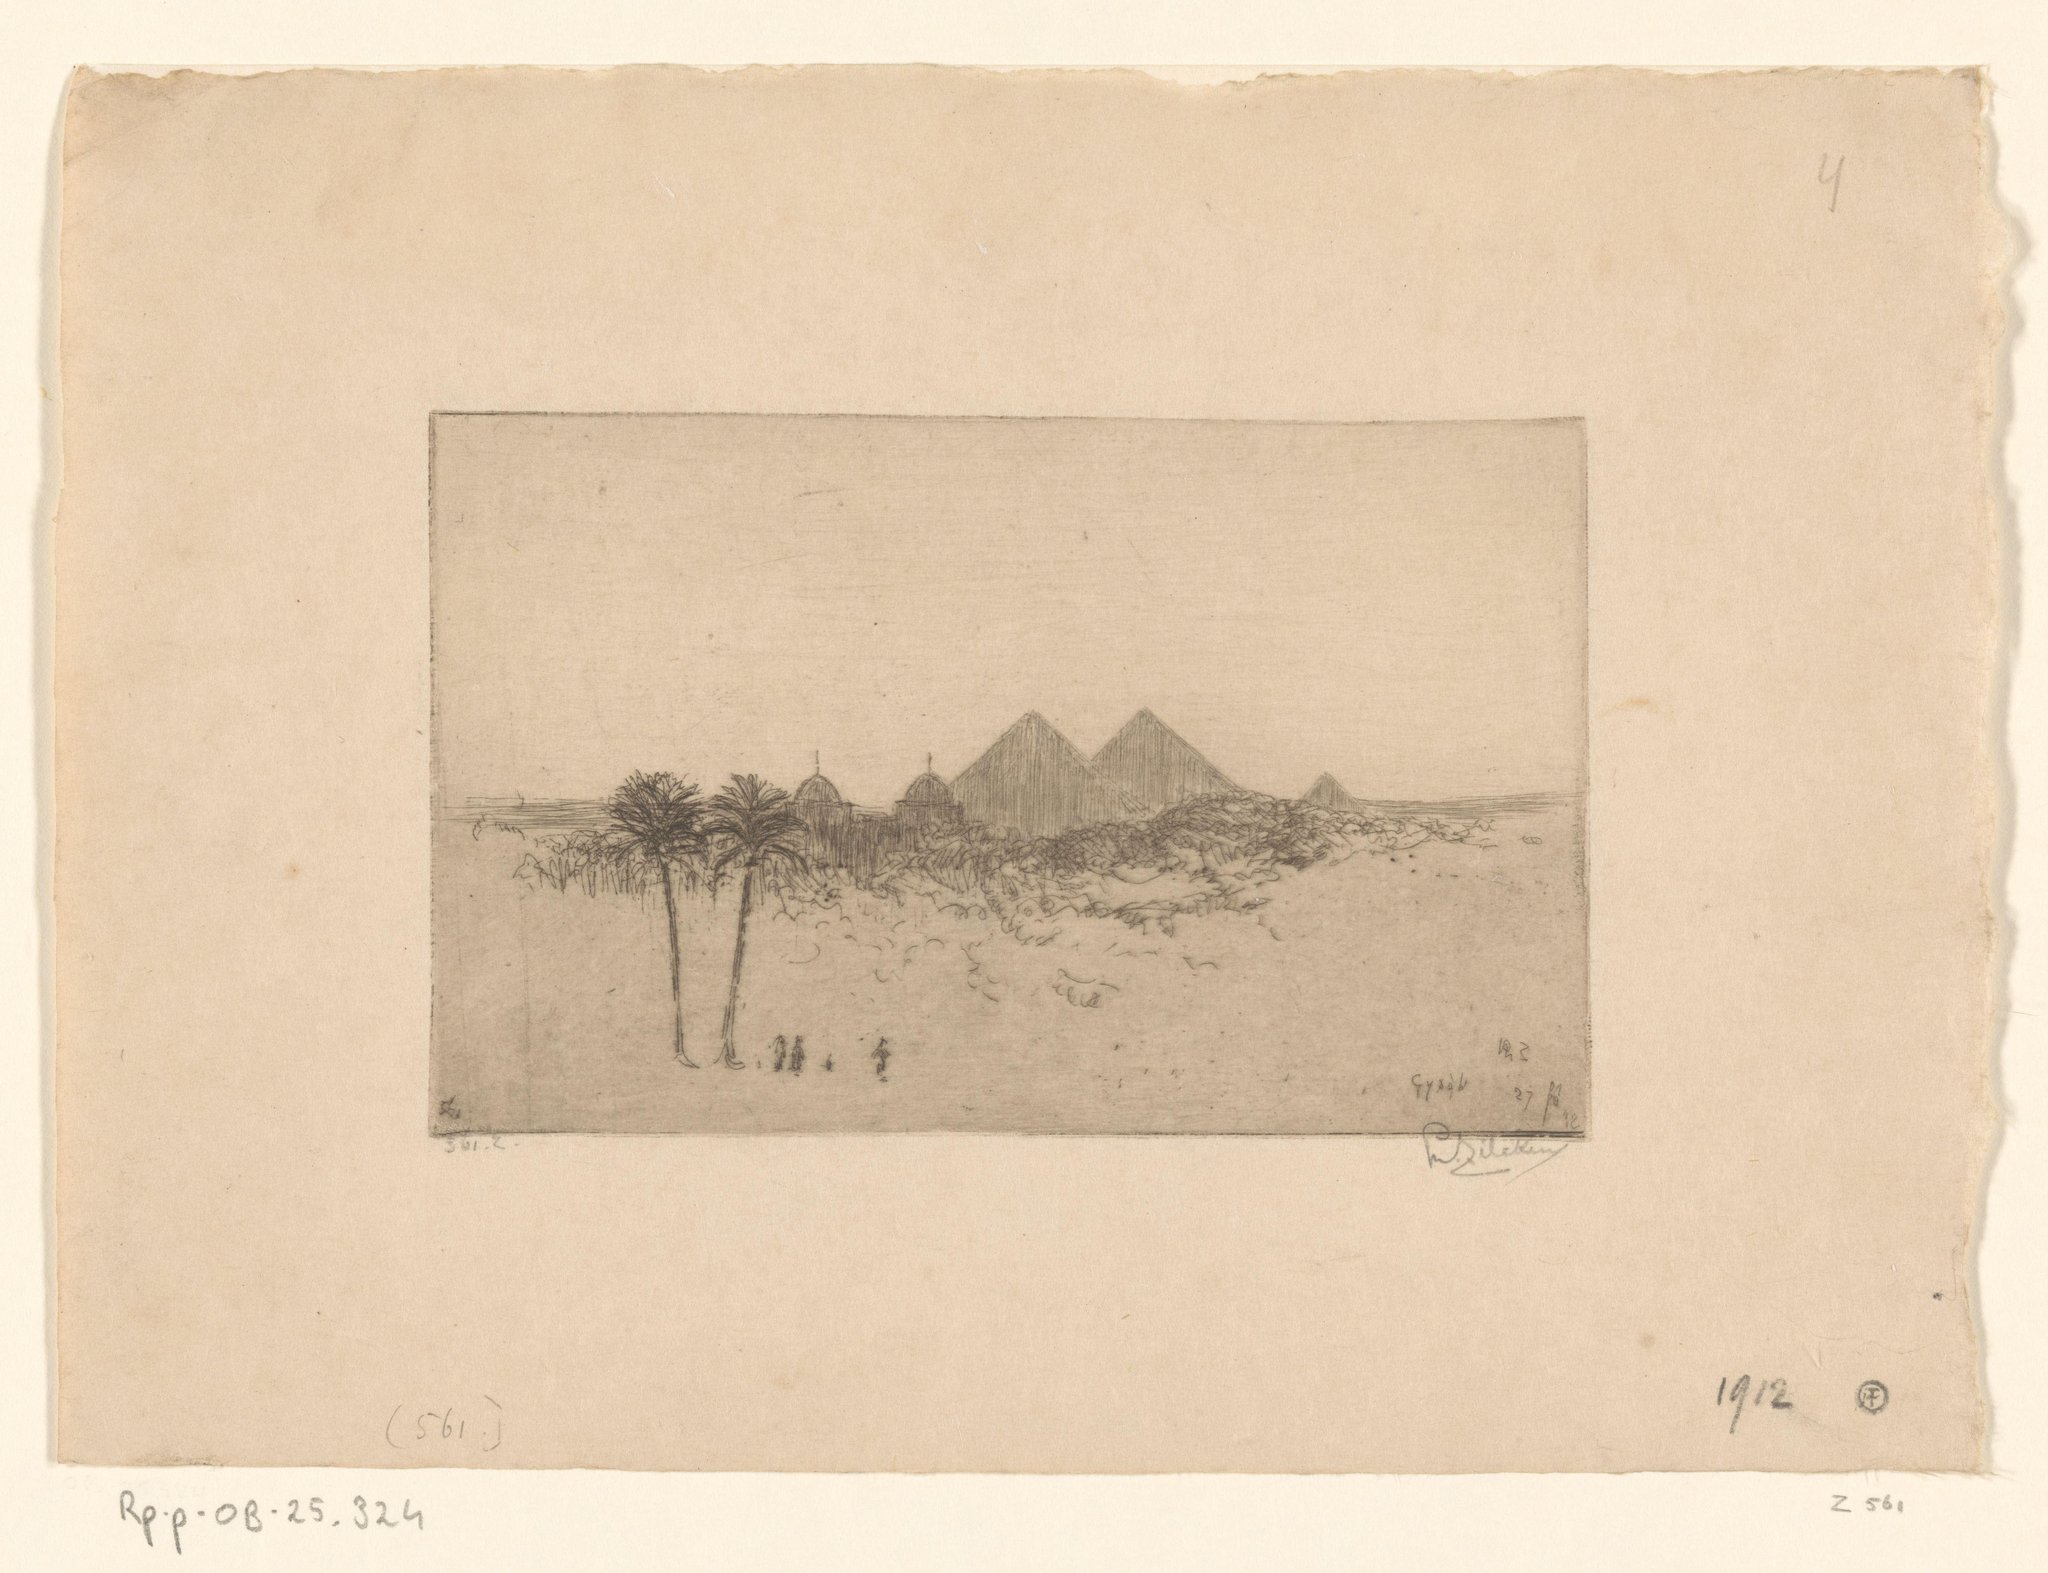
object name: print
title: Les pyramides, vues de Gîzèz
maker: philip zilcken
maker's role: draughtsman, painter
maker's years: 1857-1930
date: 1912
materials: paper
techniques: drypoint, etching, intaglio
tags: desert, pyramid (marking grave)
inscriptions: collector's mark: Lugt 2228, collector's mark: Lugt 2760